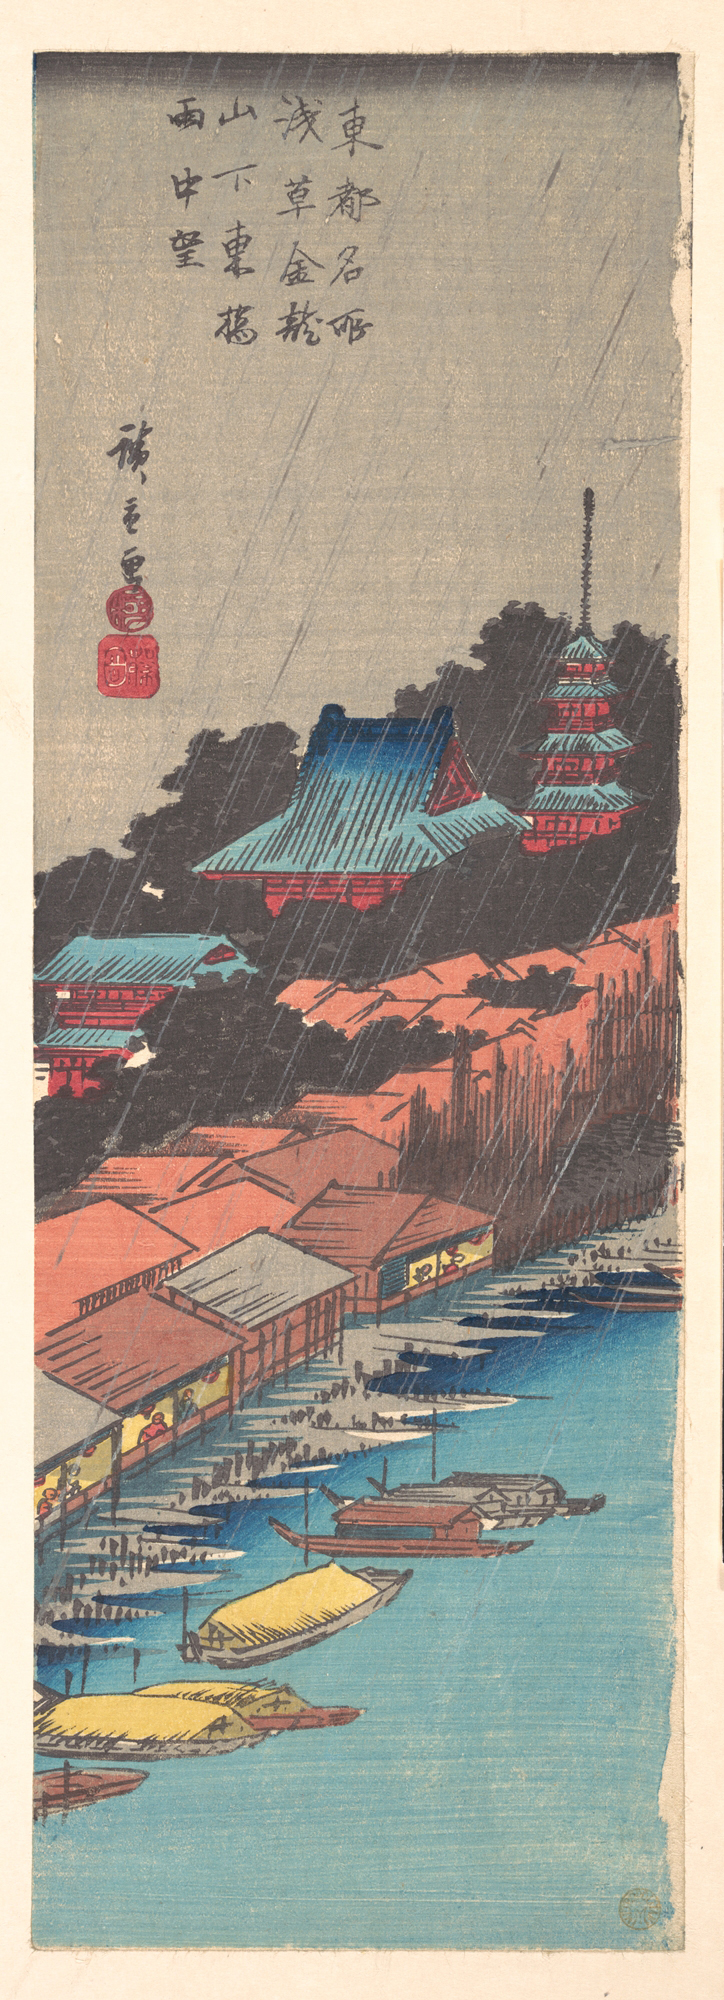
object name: print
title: View of the Asakusa Kinryuzan Temple from the Azuma Bridge in the Rain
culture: japanese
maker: utagawa hiroshige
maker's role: artist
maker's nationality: japanese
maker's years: 1797-1858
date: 1840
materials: ink, paper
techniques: woodblock print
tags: temples,rain,boats